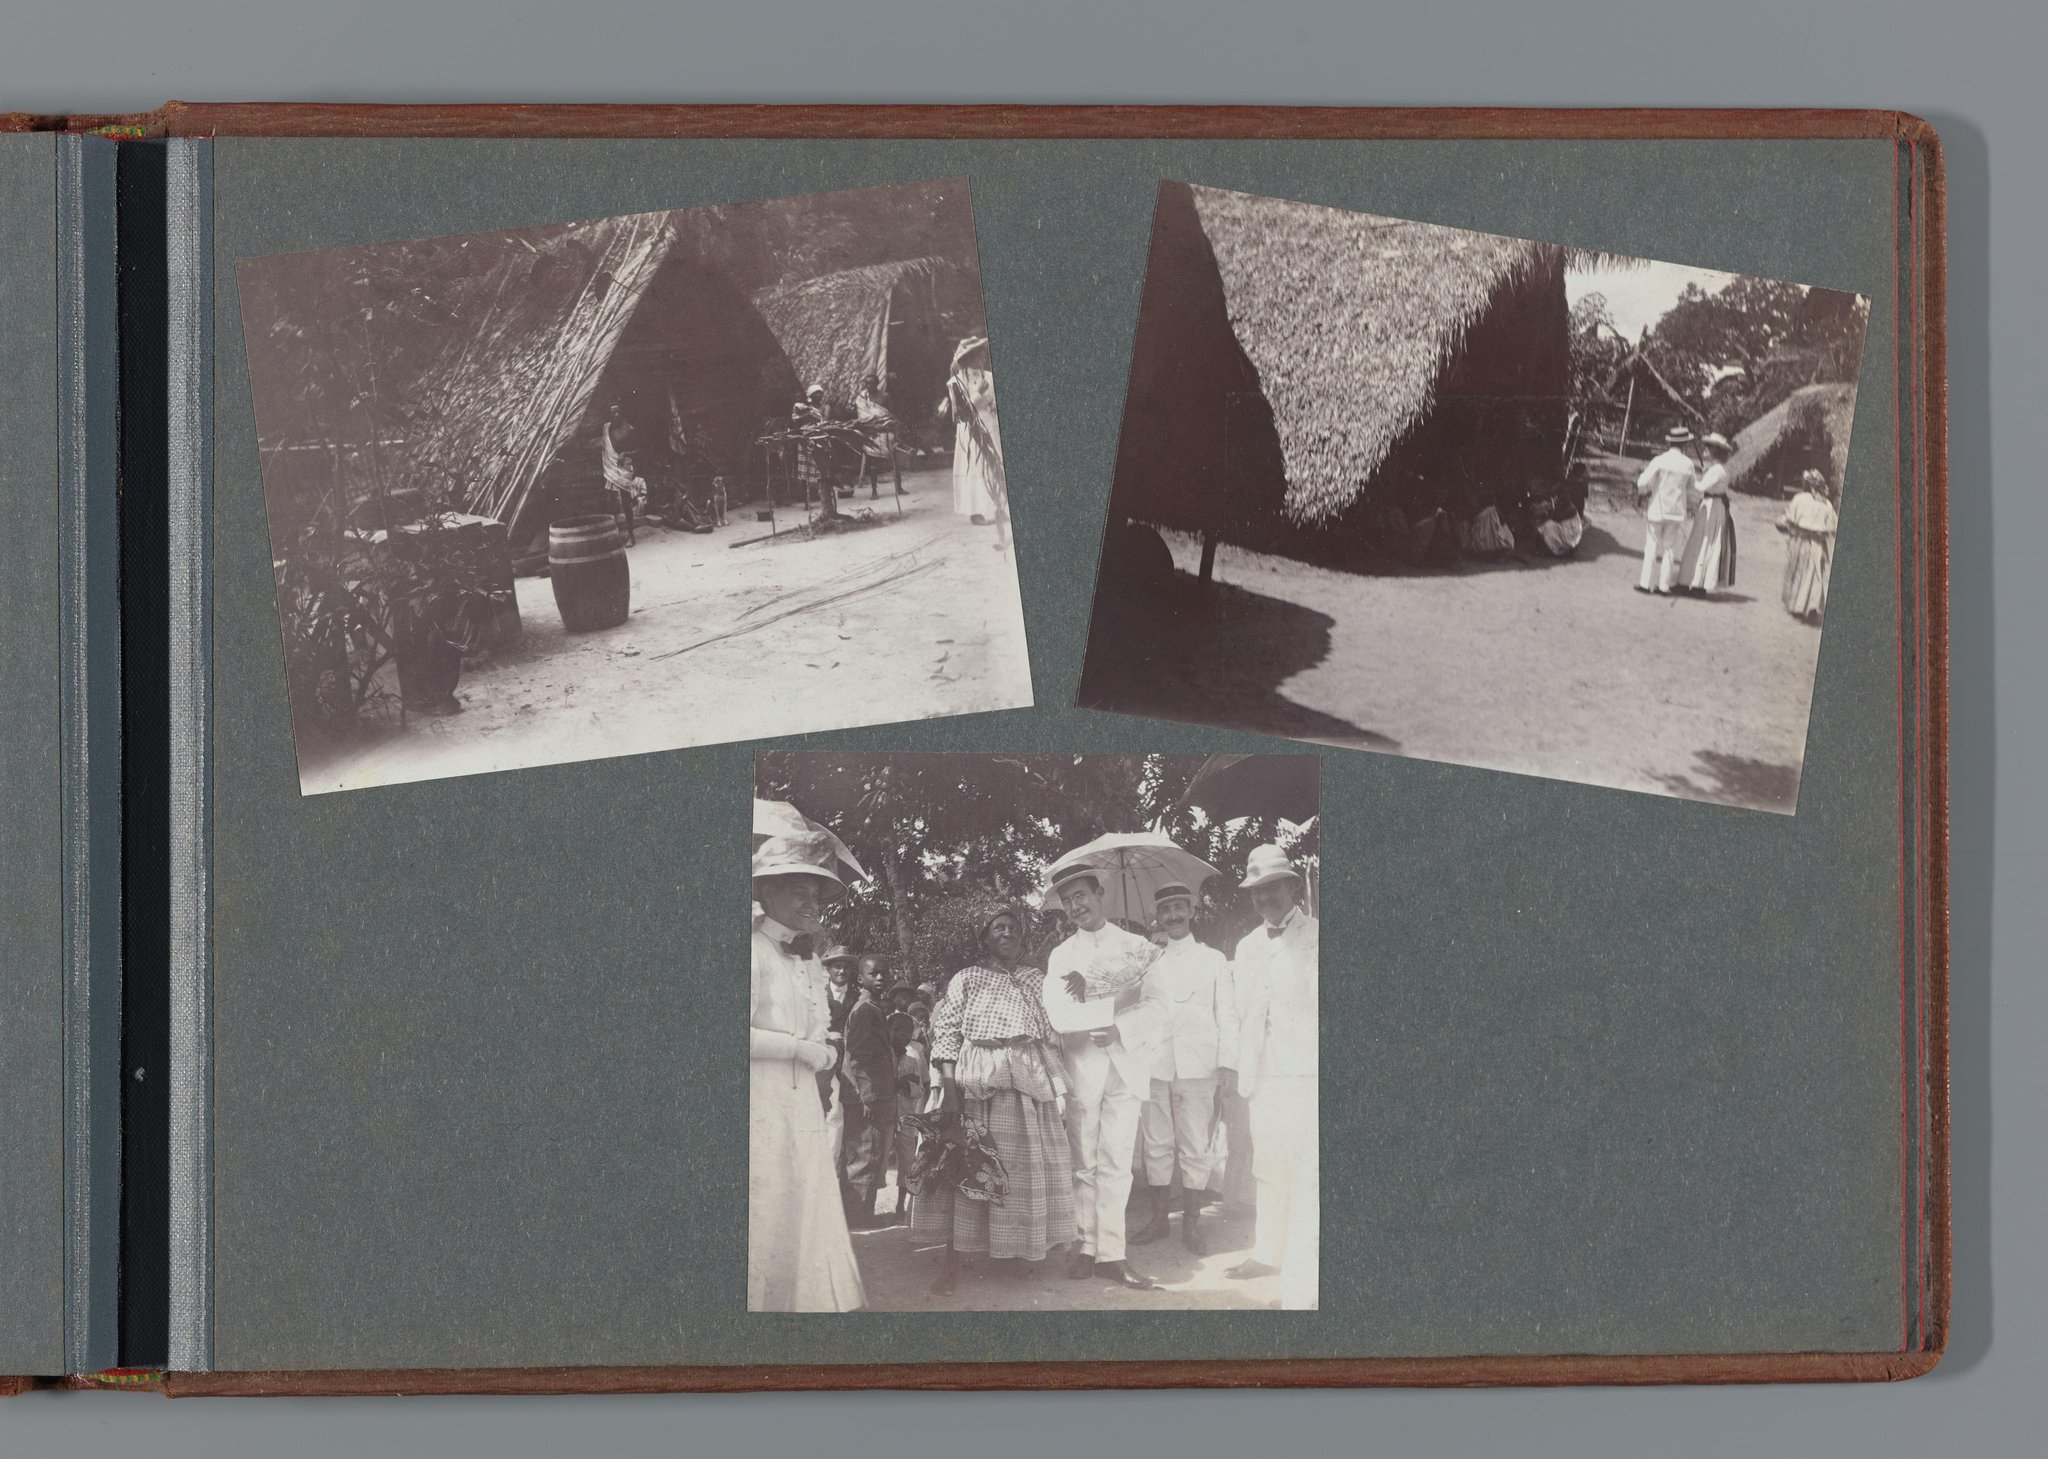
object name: photograph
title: Hutten en hun Surinaamse bewoners; rechts nog net een Westers geklede vrouw te zien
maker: Anonymous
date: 1905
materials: cardboard, paper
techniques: photography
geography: paramaribo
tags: suriname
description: Hutten en hun Surinaamse bewoners; rechts nog net een Westers geklede vrouw te zien. Onderdeel van fotoalbum 'Suriname'.